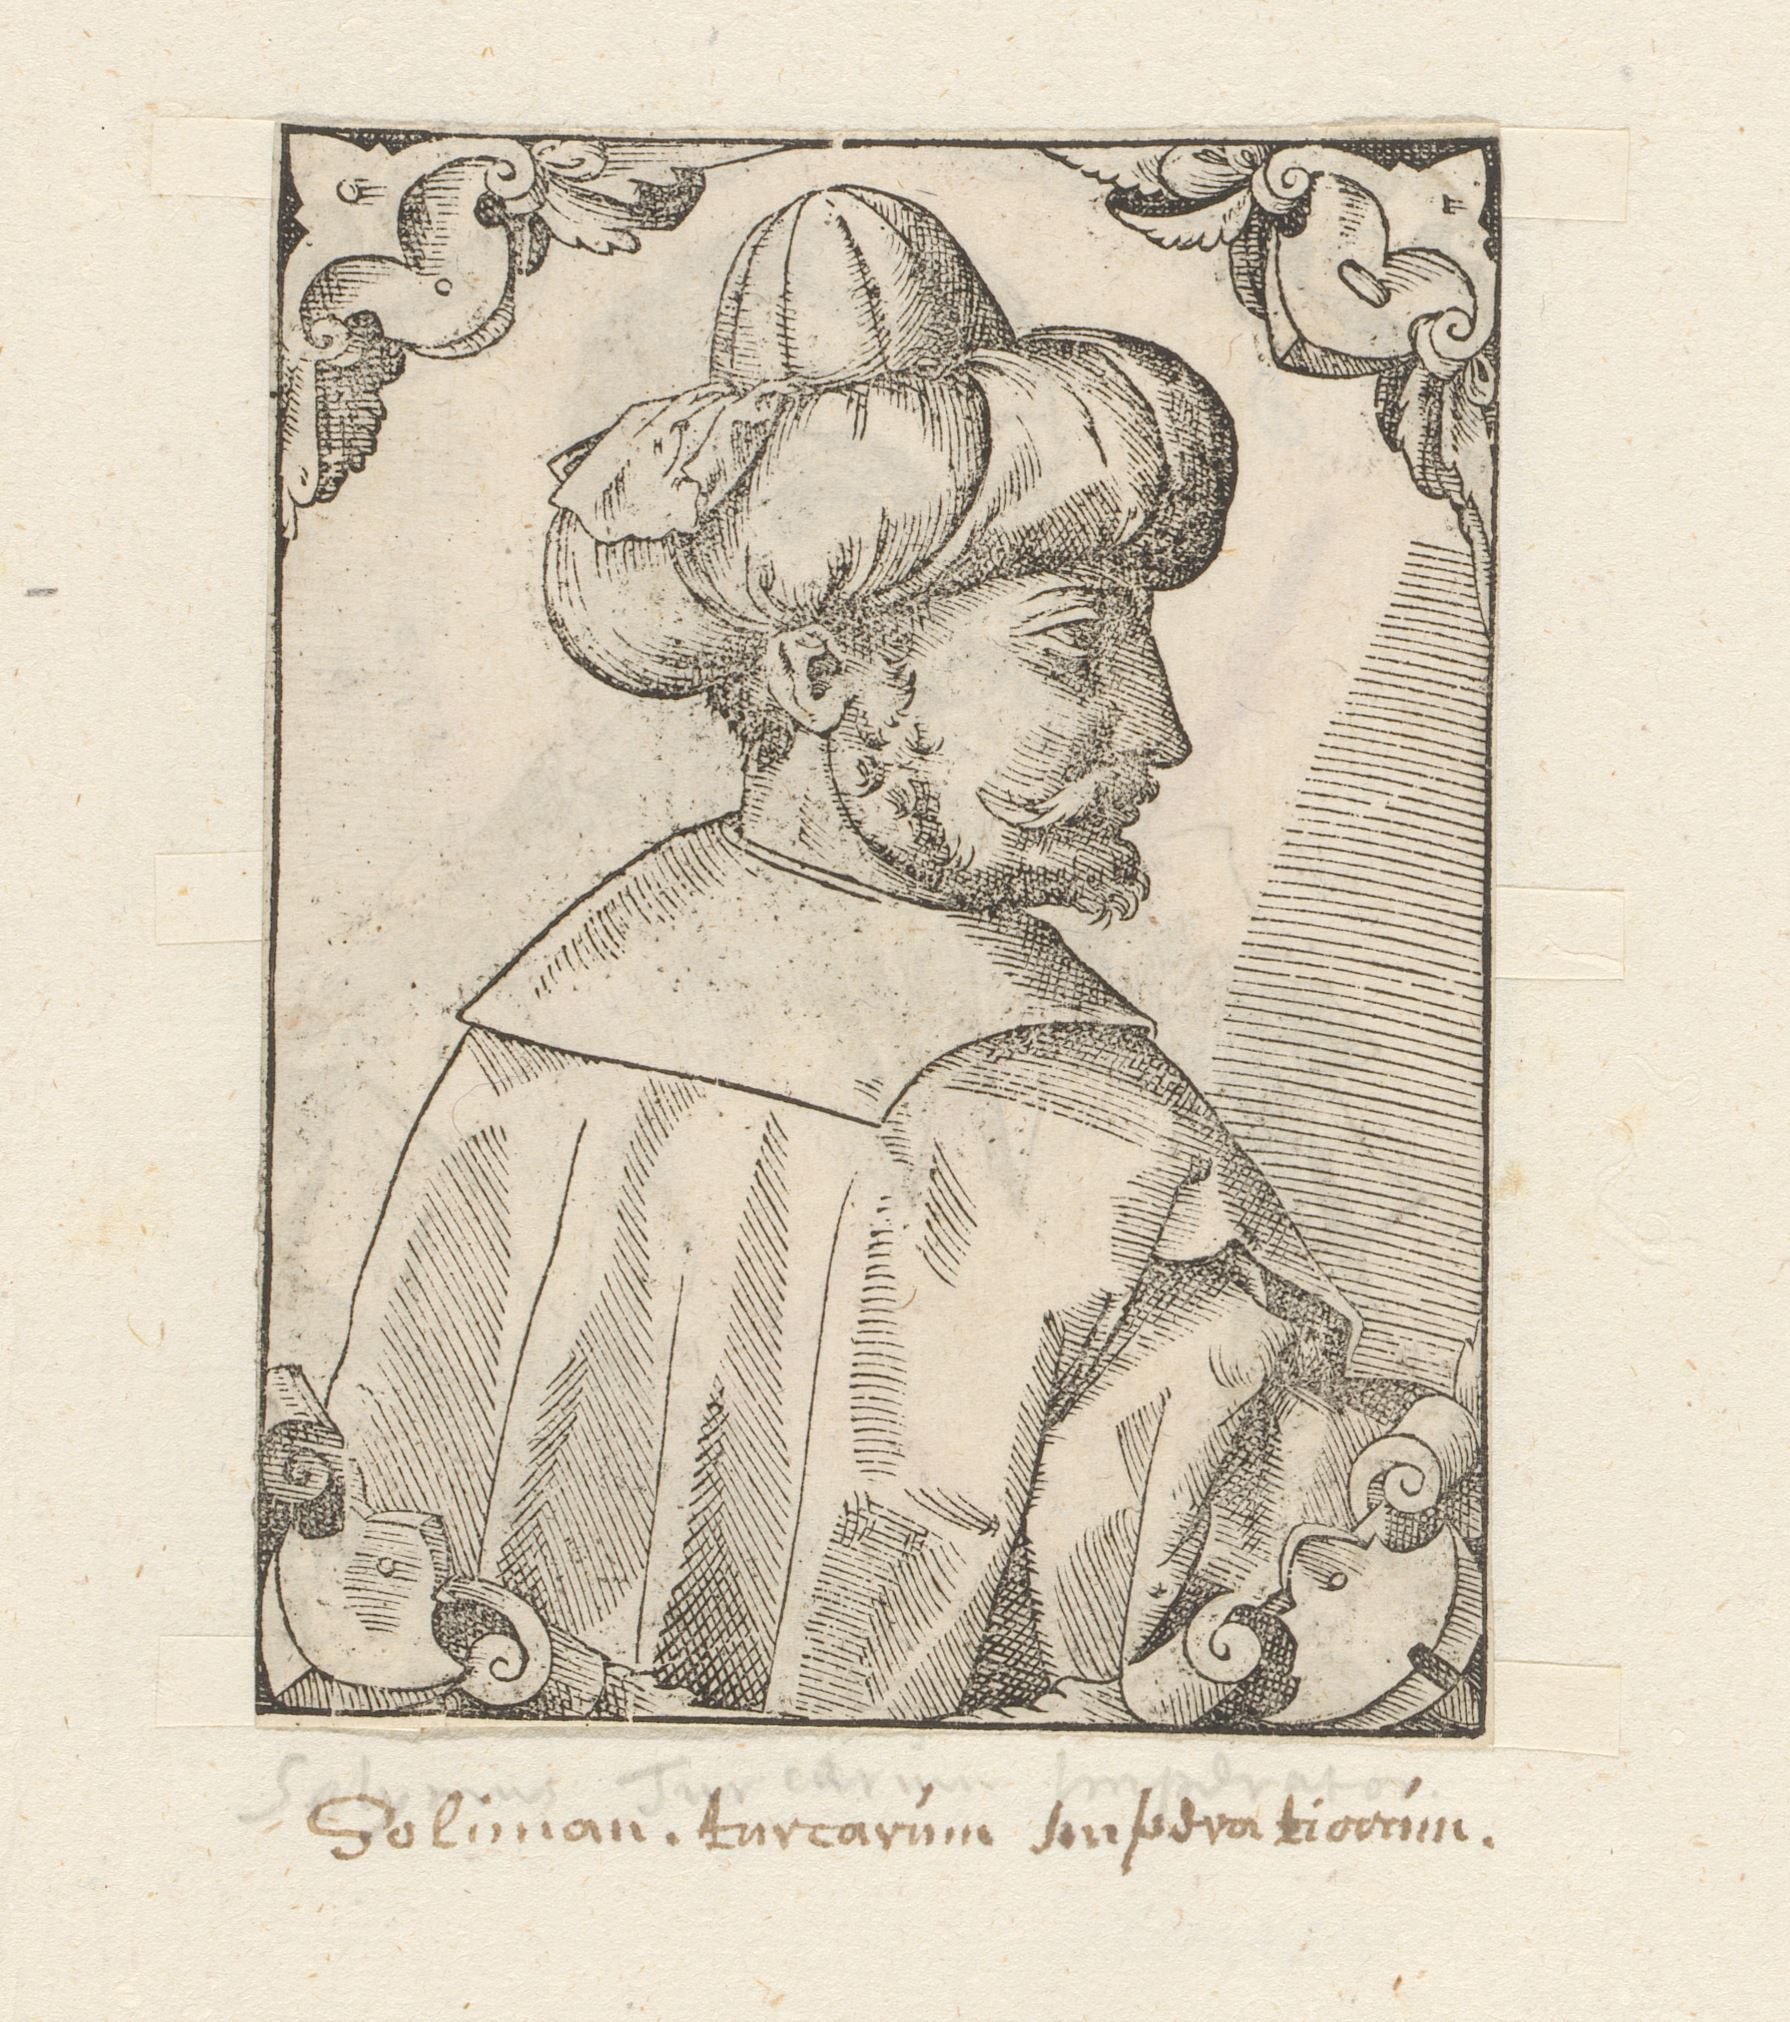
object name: print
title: Portret van sultan Selim I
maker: Anonymous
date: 1549-1575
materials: paper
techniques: woodcut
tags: historical persons, ruler, sovereign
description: Prent gebruikt in: Giovio, Paolo. Elogia Virorum bellica virtute illustrium (...). Bazel: Peter Perna, 1575.